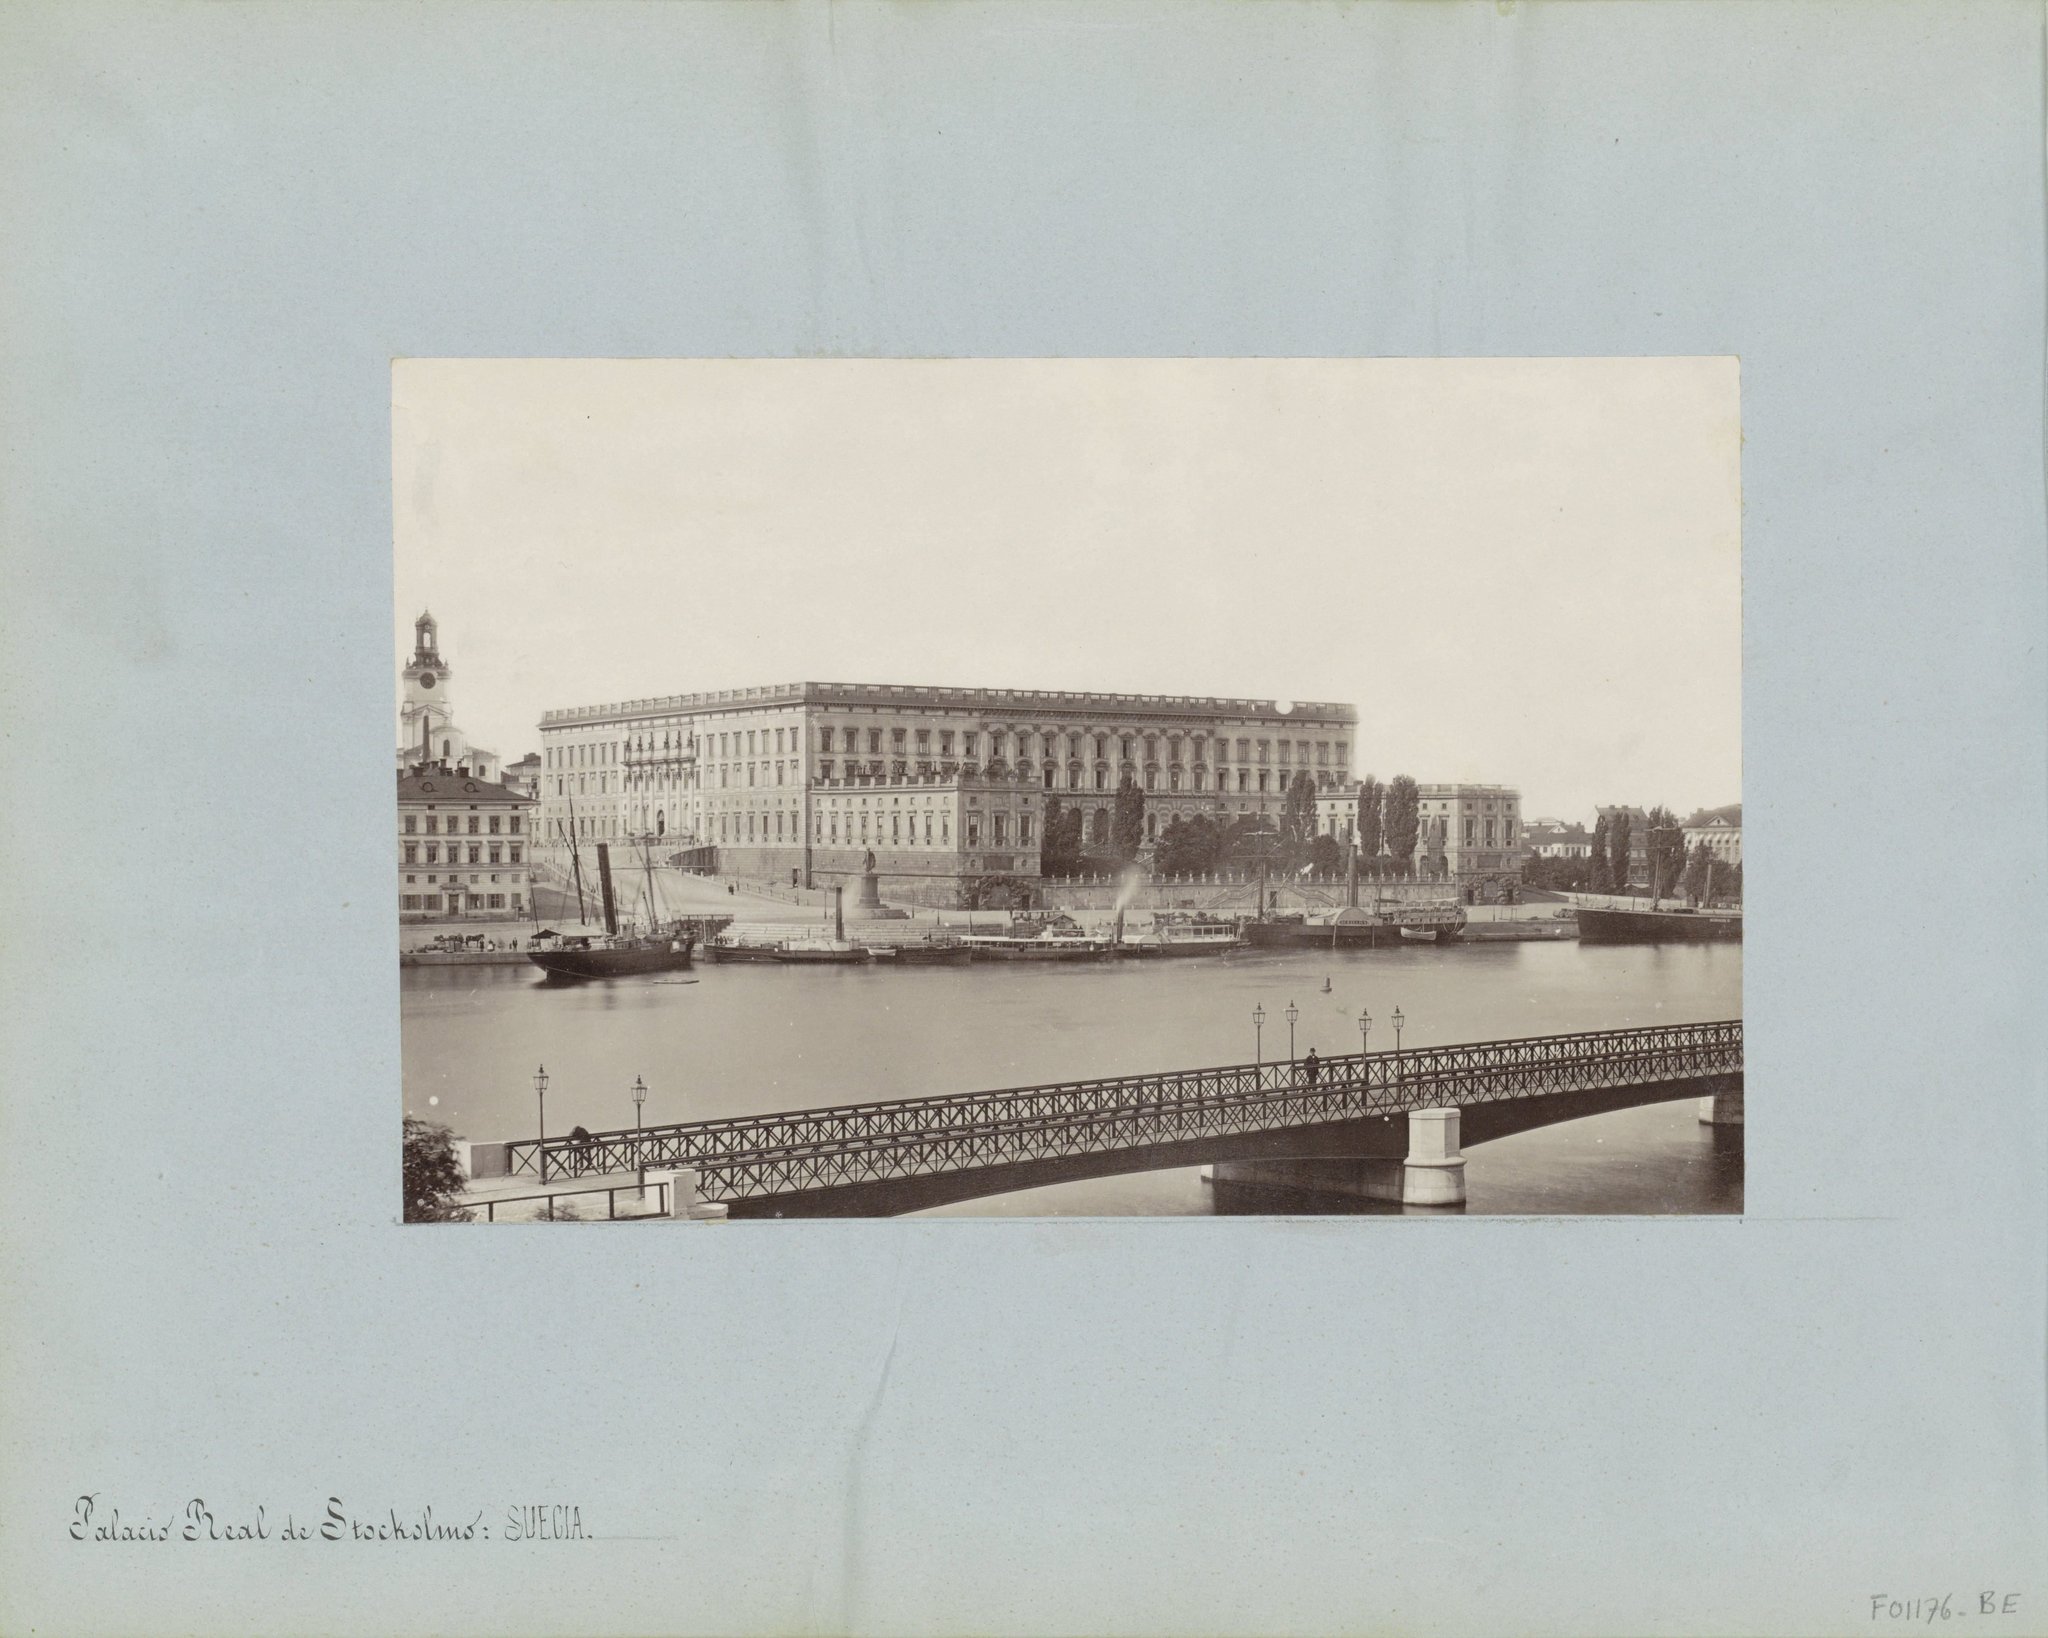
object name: photograph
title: Palacio Real de Stockolmo: SUECIA.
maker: Anonymous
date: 1850-1876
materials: photographic support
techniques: albumen print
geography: stockholm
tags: palace, travelling; tourism, bridge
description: Onderdeel van Reisalbum met foto's en tekeningen van Manuel Mayo 1876.